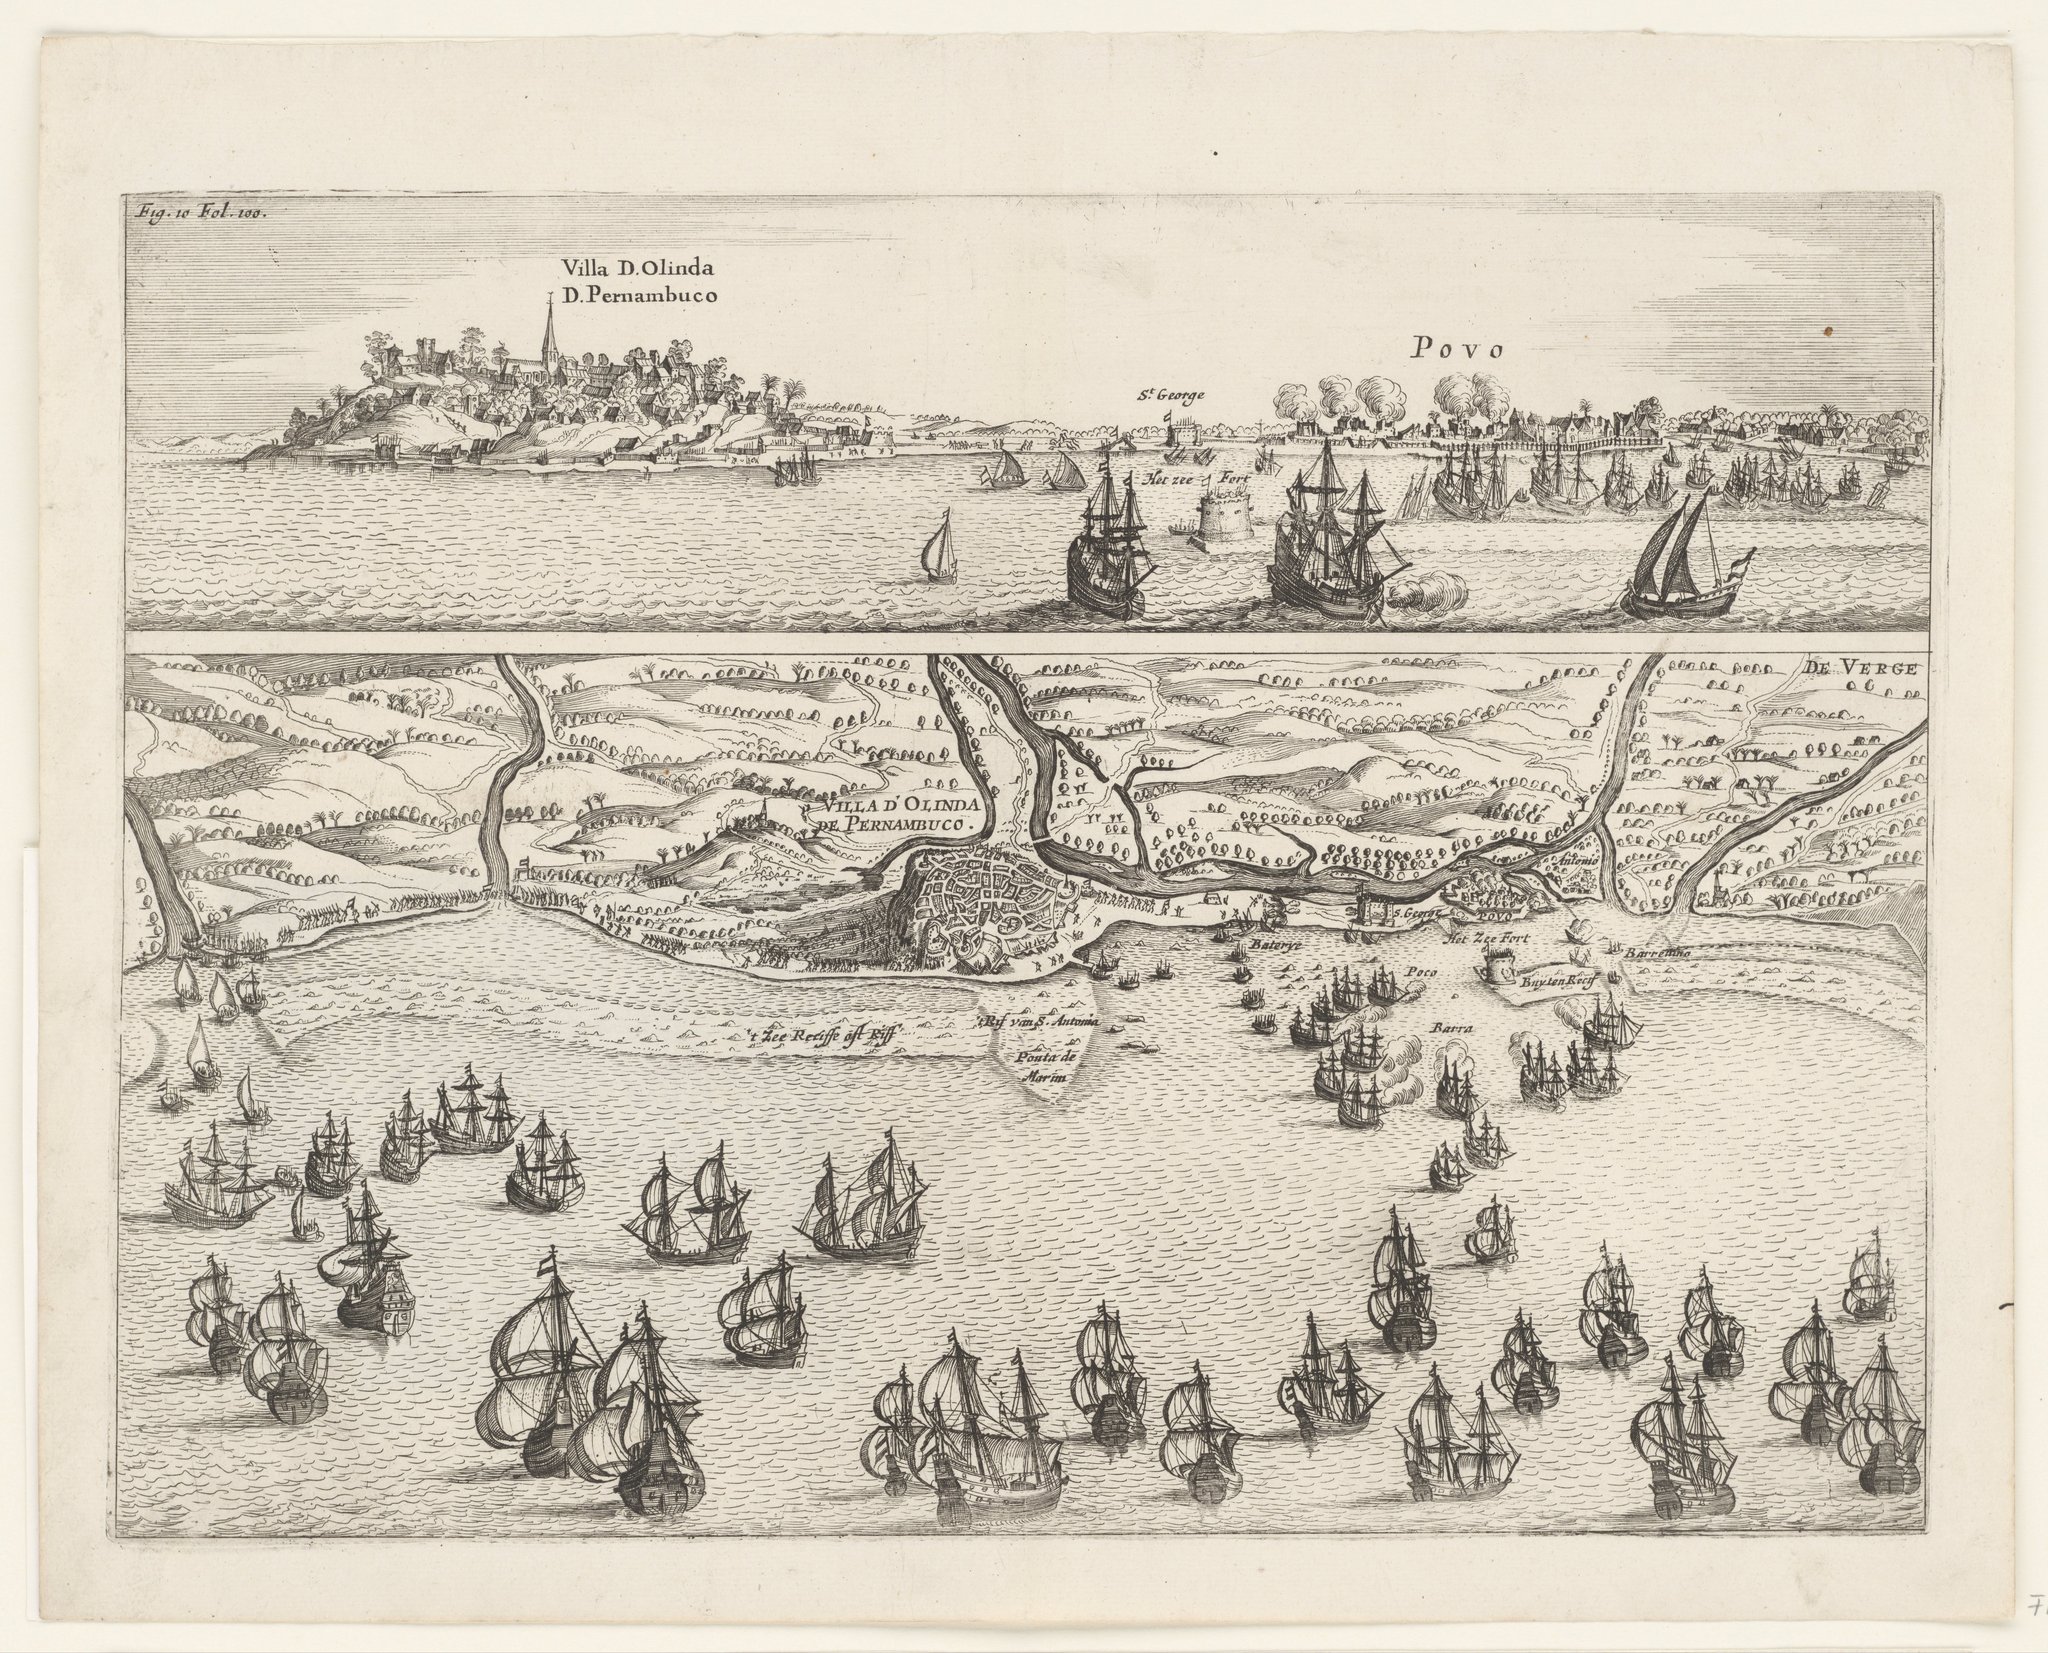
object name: print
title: Verovering van Olinda in Brazilië door generaal Hendrick C. Loncq, 1630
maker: Anonymous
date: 1651-1652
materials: paper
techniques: etching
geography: northern netherlands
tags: capture of city (after the siege)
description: Verovering van de stad Olinda te Pernambuco in Brazilië door een vloot van de WIC onder admiraal Hendrick C. Loncq, februari of maart 1630. Twee voorstellingen. Boven een gezicht op Olinda vanaf het water met enkele brandende gebouwen. Onder de Hollandse vloot gelegen voor Olinda aan de Braziliaanse kust. Gemerkt linksboven: fig. 10, fol. 100.